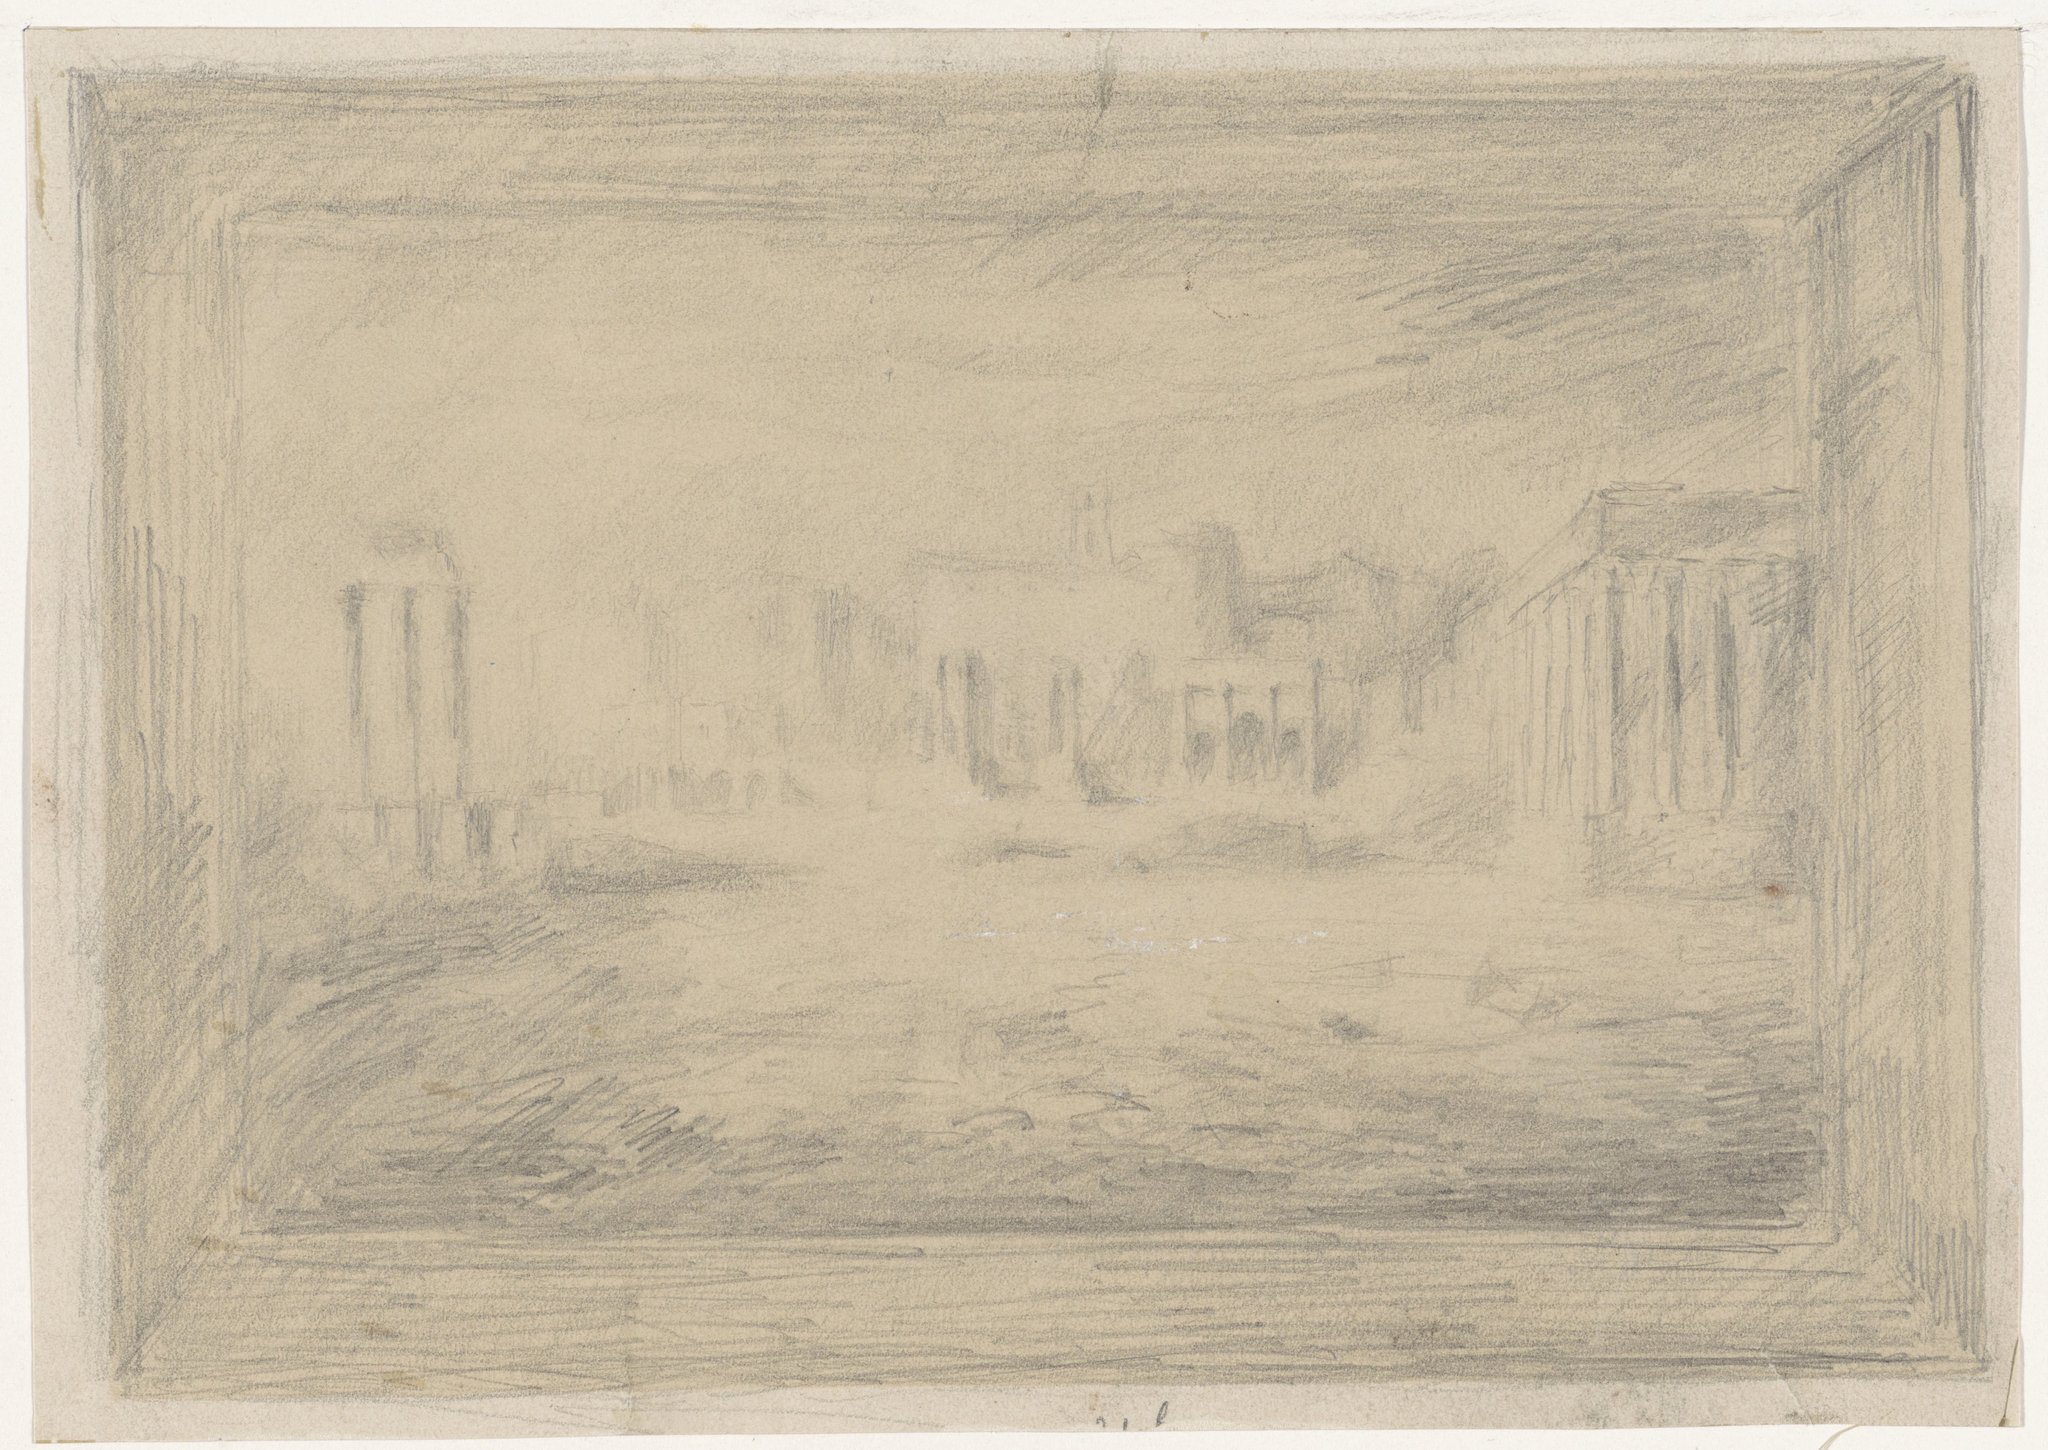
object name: drawing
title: Forum Romanum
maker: thomas cool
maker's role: draughtsman, painter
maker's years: 1851-1904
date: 1861-1904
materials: paper, pencil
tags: landscape with ruins, rome